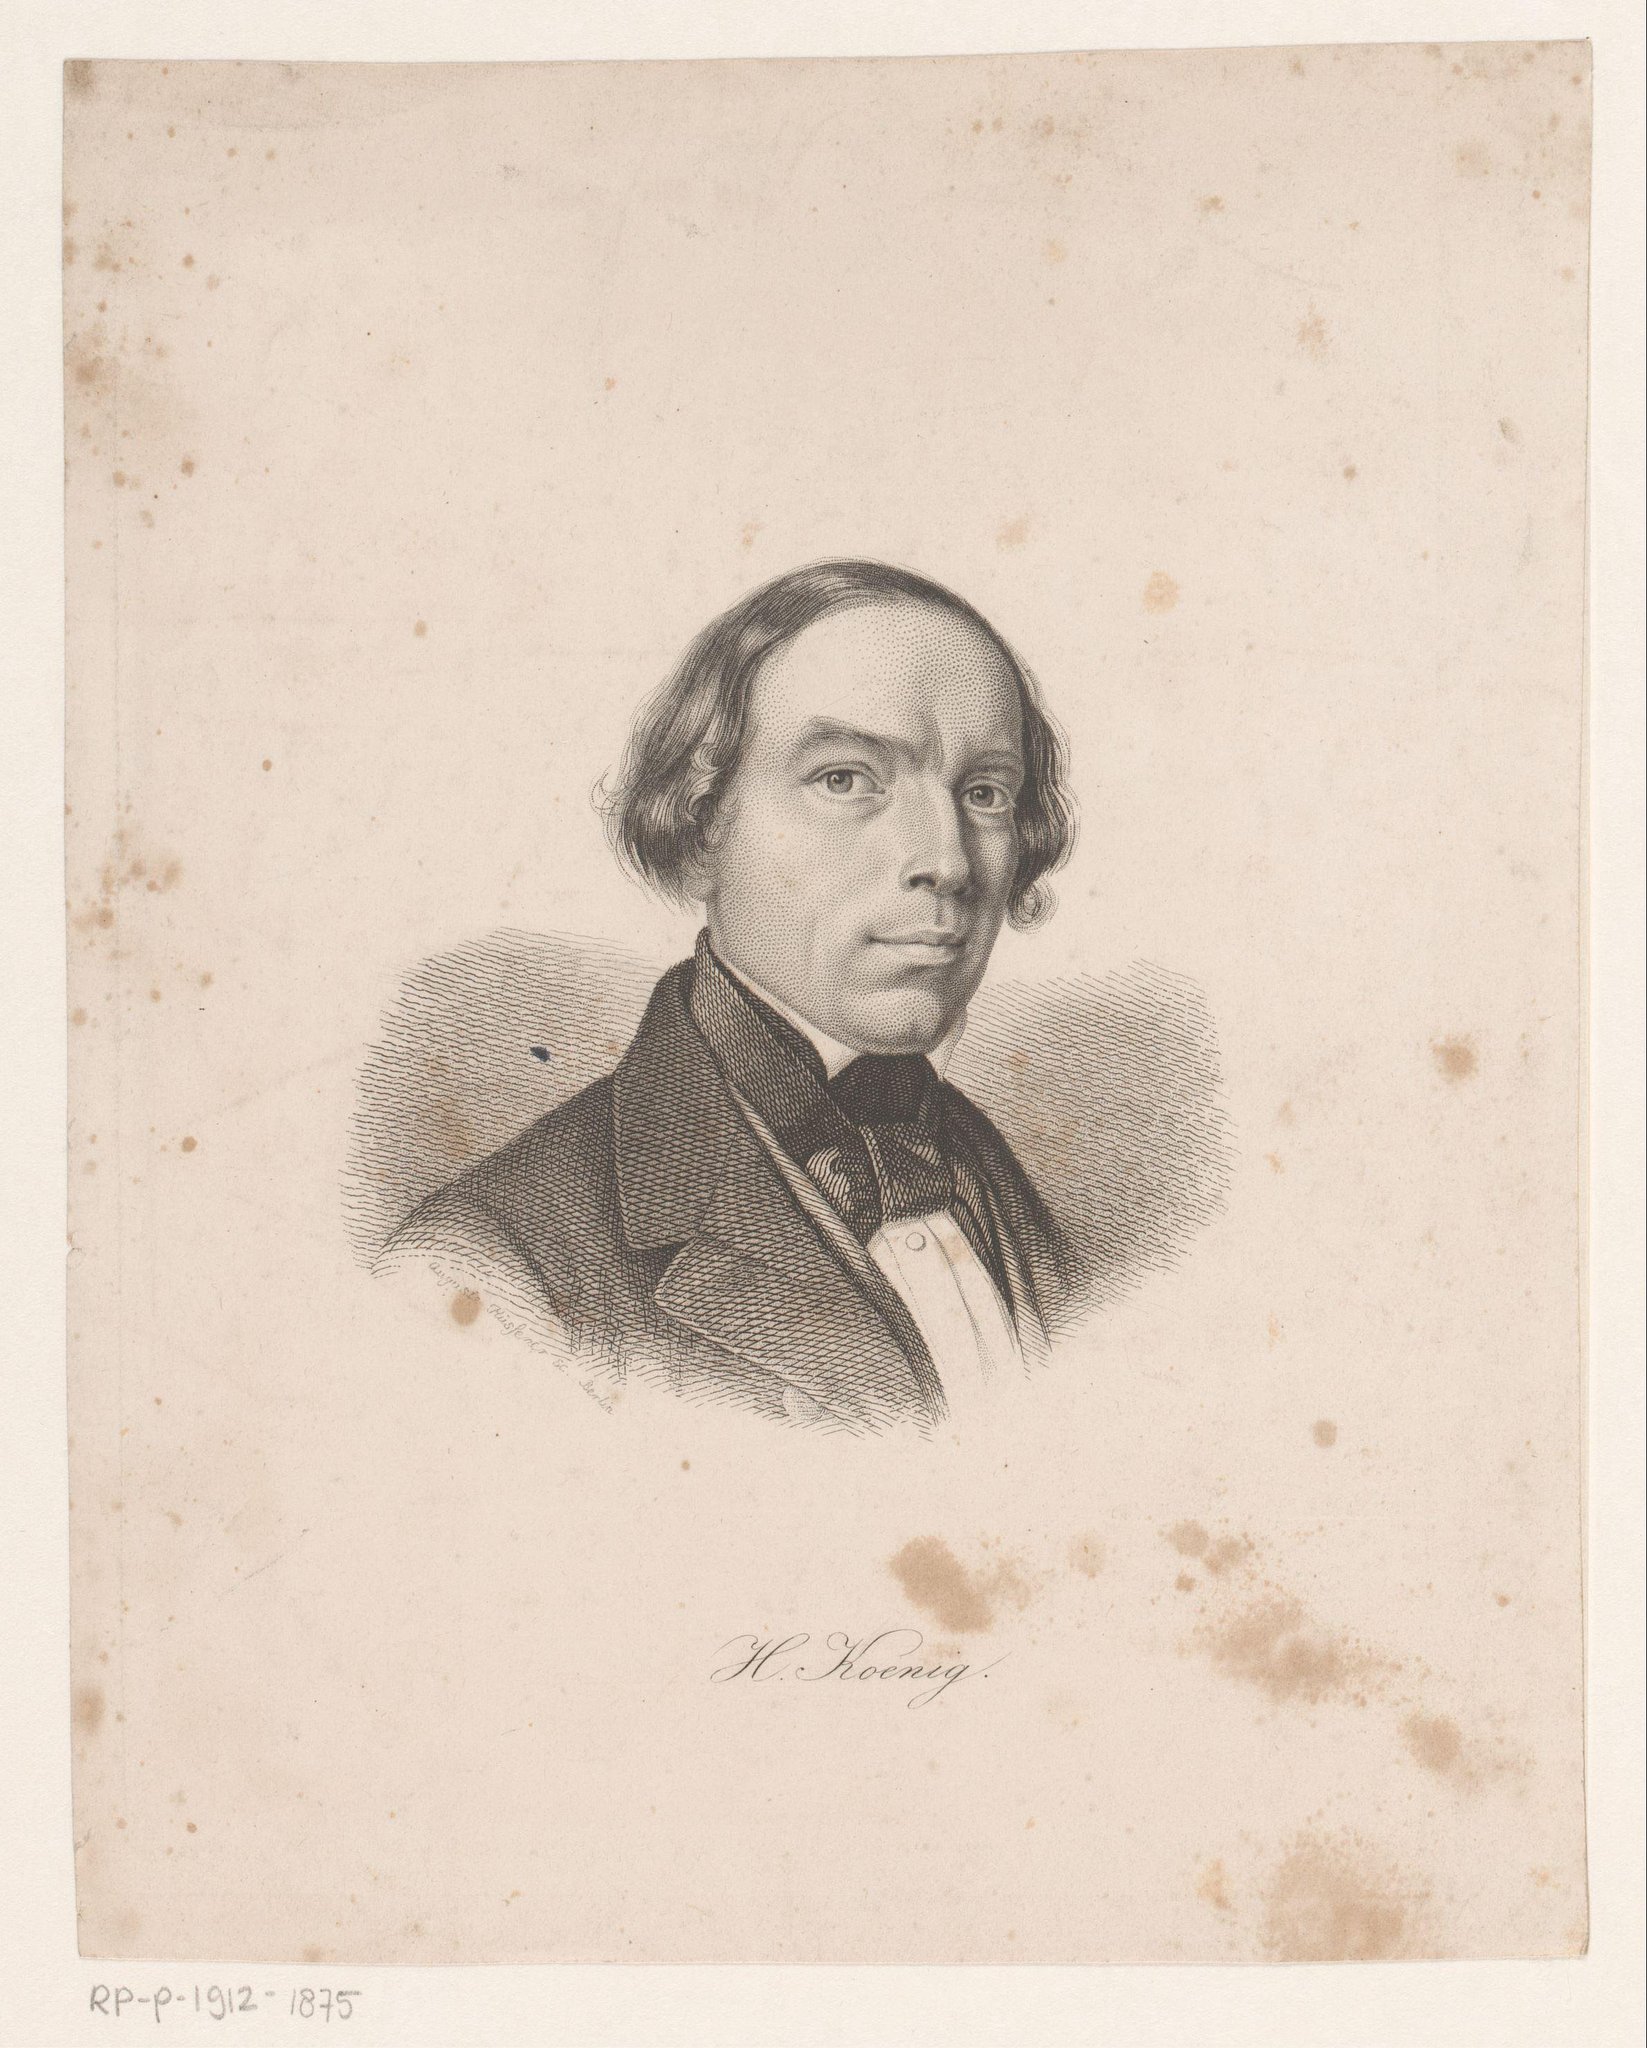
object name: print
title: Portret van Heinrich König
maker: auguste hüssener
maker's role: print maker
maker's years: 1789-1877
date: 1799-1877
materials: paper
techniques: etching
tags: print maker, heinrich joseph könig, historical persons, writer, poet, author, portrait, self-portrait of graphic artist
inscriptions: collector's mark: Lugt 2228